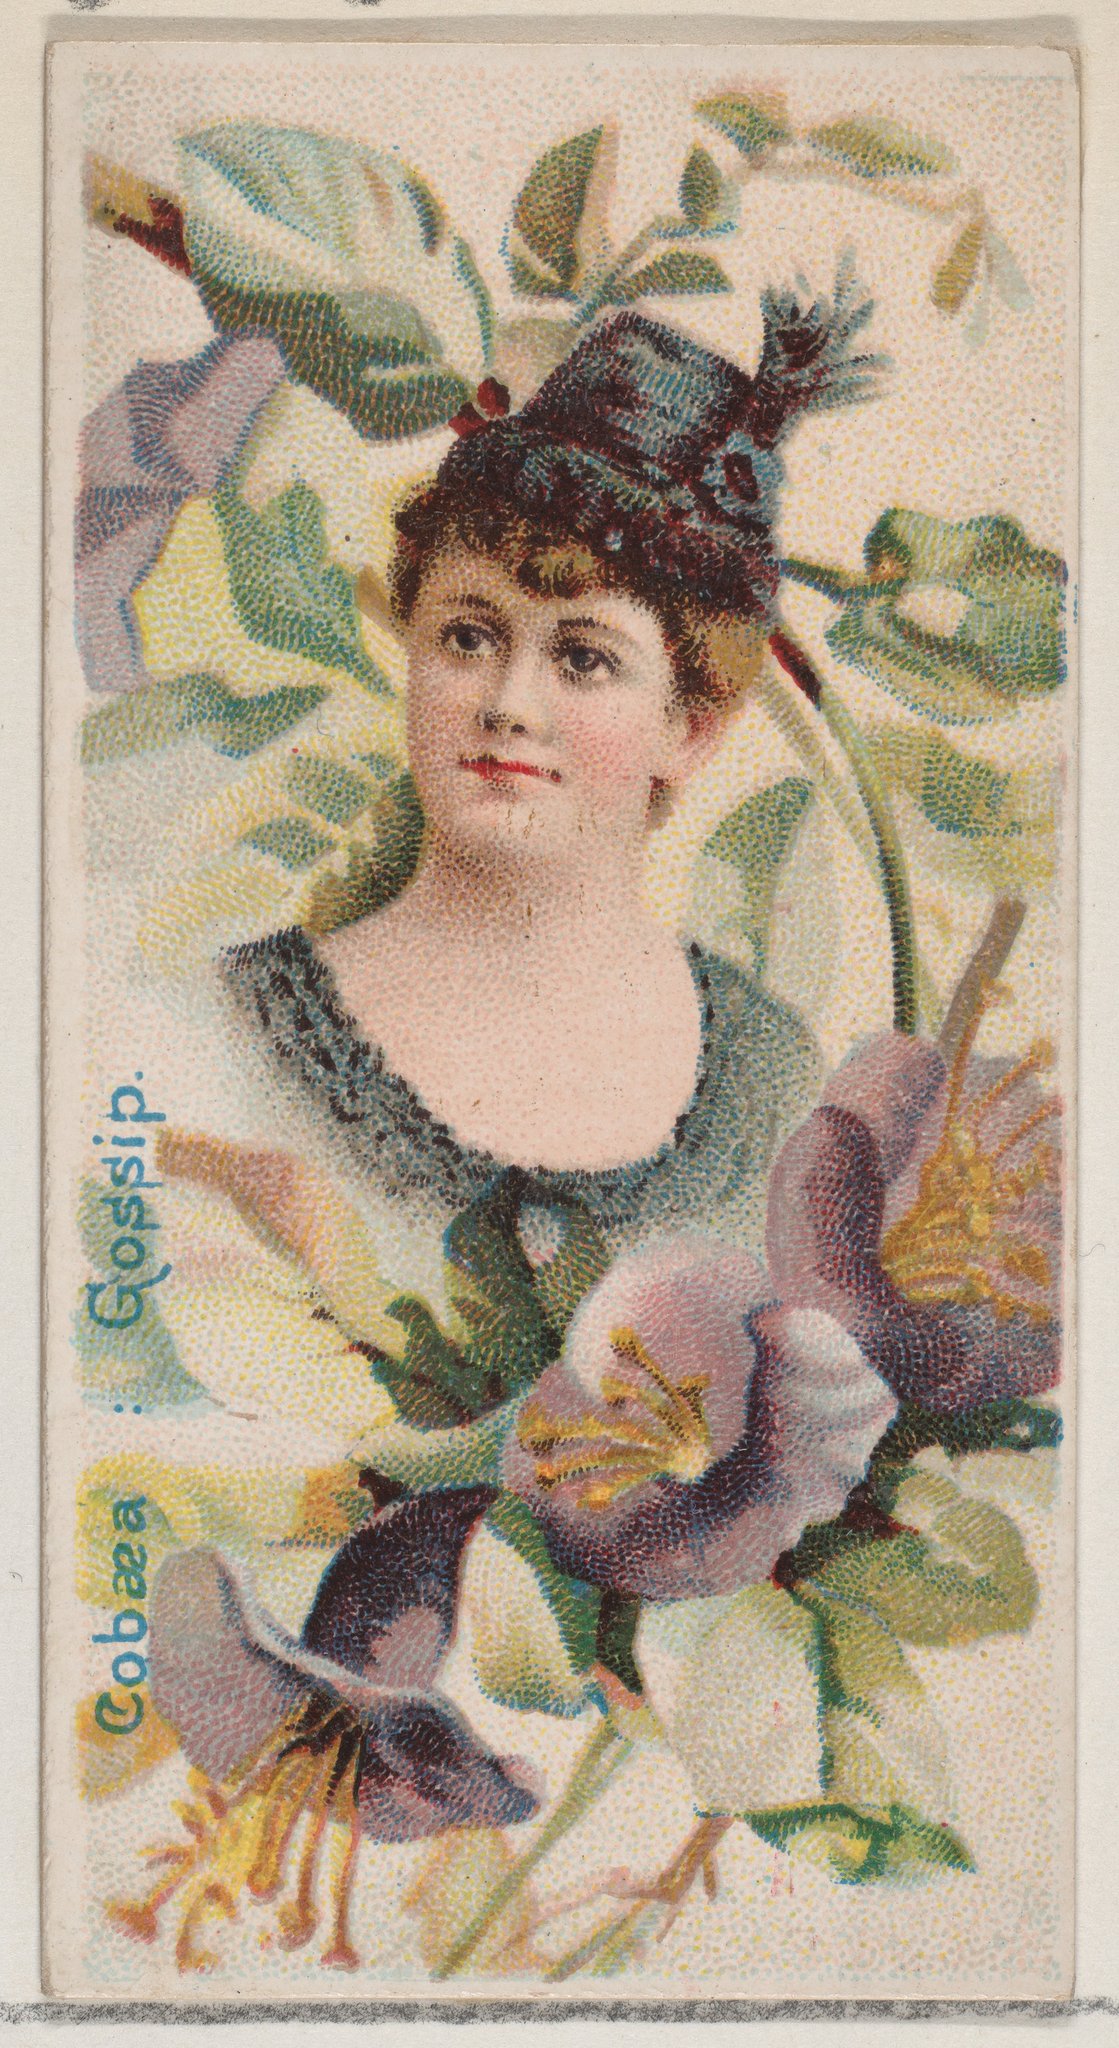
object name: print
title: Cobaea: Gossip, from the series Floral Beauties and Language of Flowers (N75) for Duke brand cigarettes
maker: american tobacco company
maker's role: publisher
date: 1892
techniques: color lithograph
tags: women,flowers